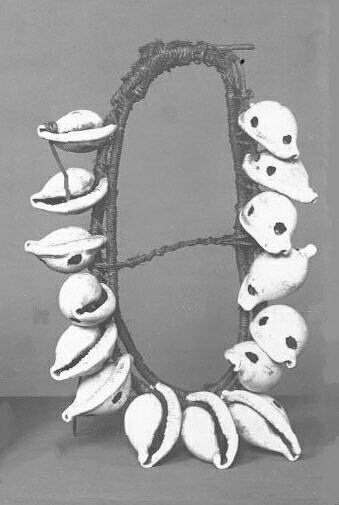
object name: strung rattle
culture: central african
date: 1867-1900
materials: cord, shell